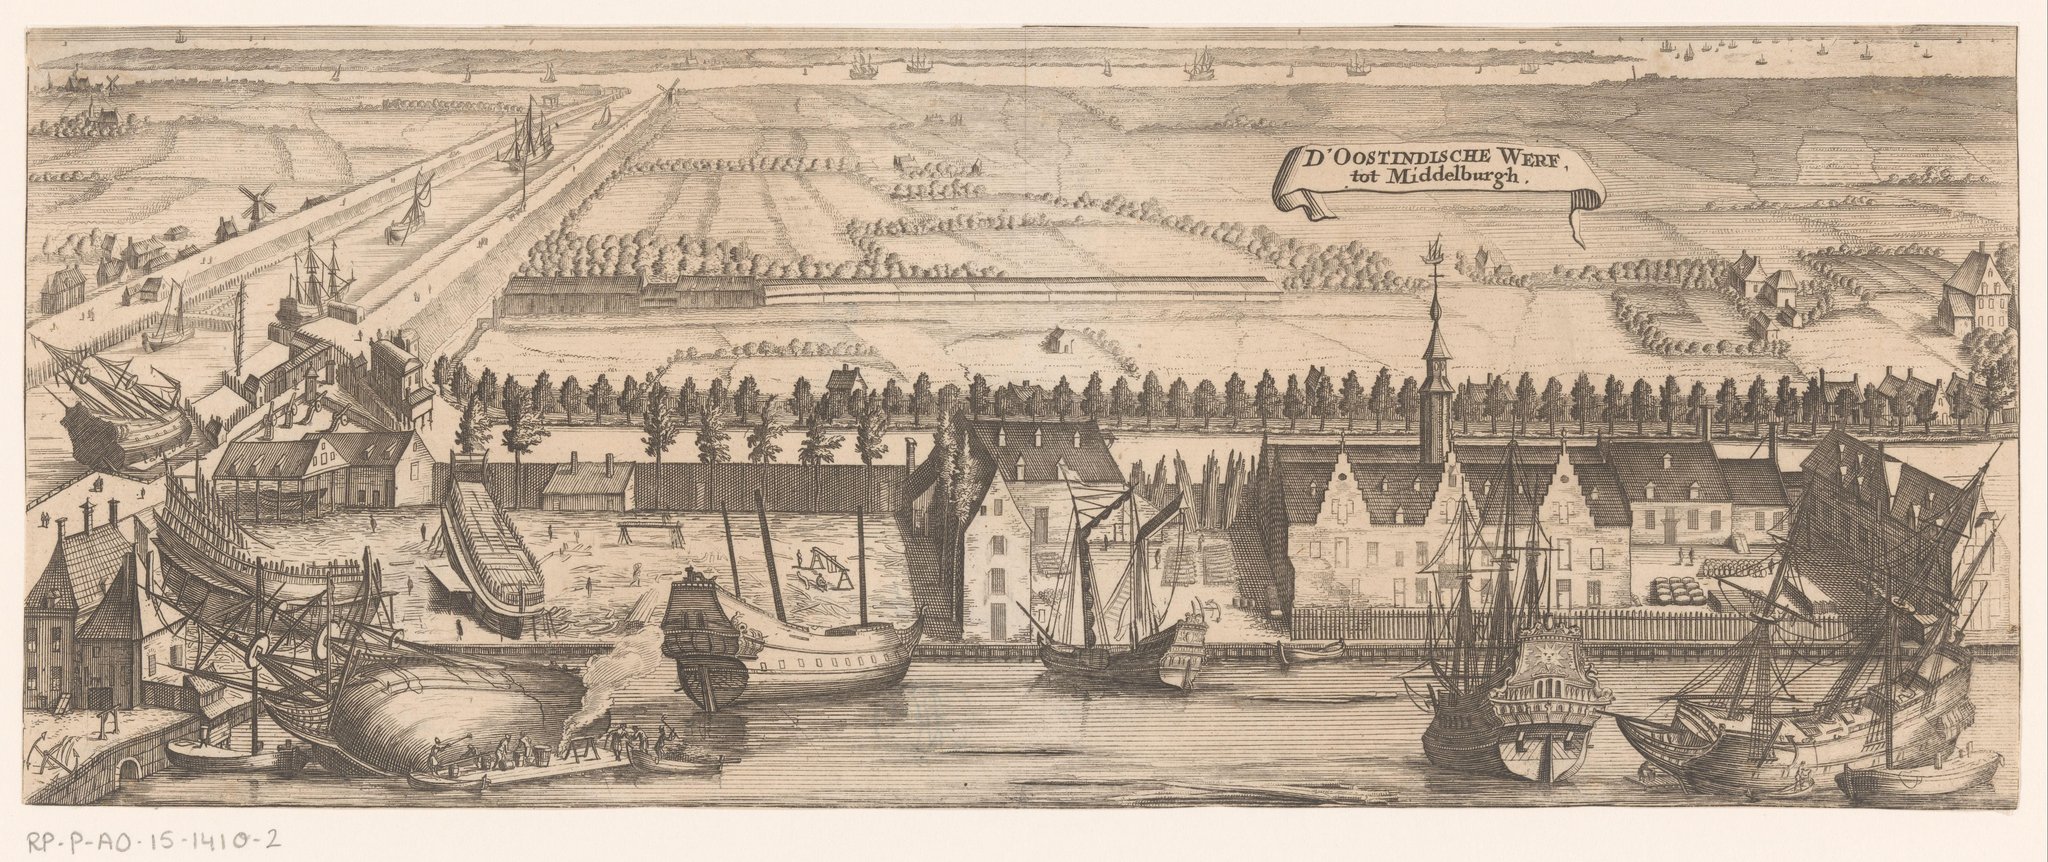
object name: print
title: Gezicht op de Oost-Indische Werf te Middelburg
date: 1696-1728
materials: paper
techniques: engraving, etching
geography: middelburg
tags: pier, quay, wharf, shipyard, shipdock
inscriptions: collector's mark: Lugt 195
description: Oorspronkelijk van één plaat gedrukt met twee andere voorstellingen (zie RP-P-AO-15-141O-3 en RP-P-AO-15-141O-4). Prent in zijn geheel ook gebruikt in: Smallegange, Mattheus. Nieuwe Cronyk van Zeeland (…). Middelburg en Amsterdam: Johannes Meertens en Abraham van Someren, 1696. En huidige voorstelling los ook gebruikt in: Aa, Pieter van der. La galerie agreable du monde (...). 66 delen. Leiden: Pieter van der Aa, 1728, dl. 20.